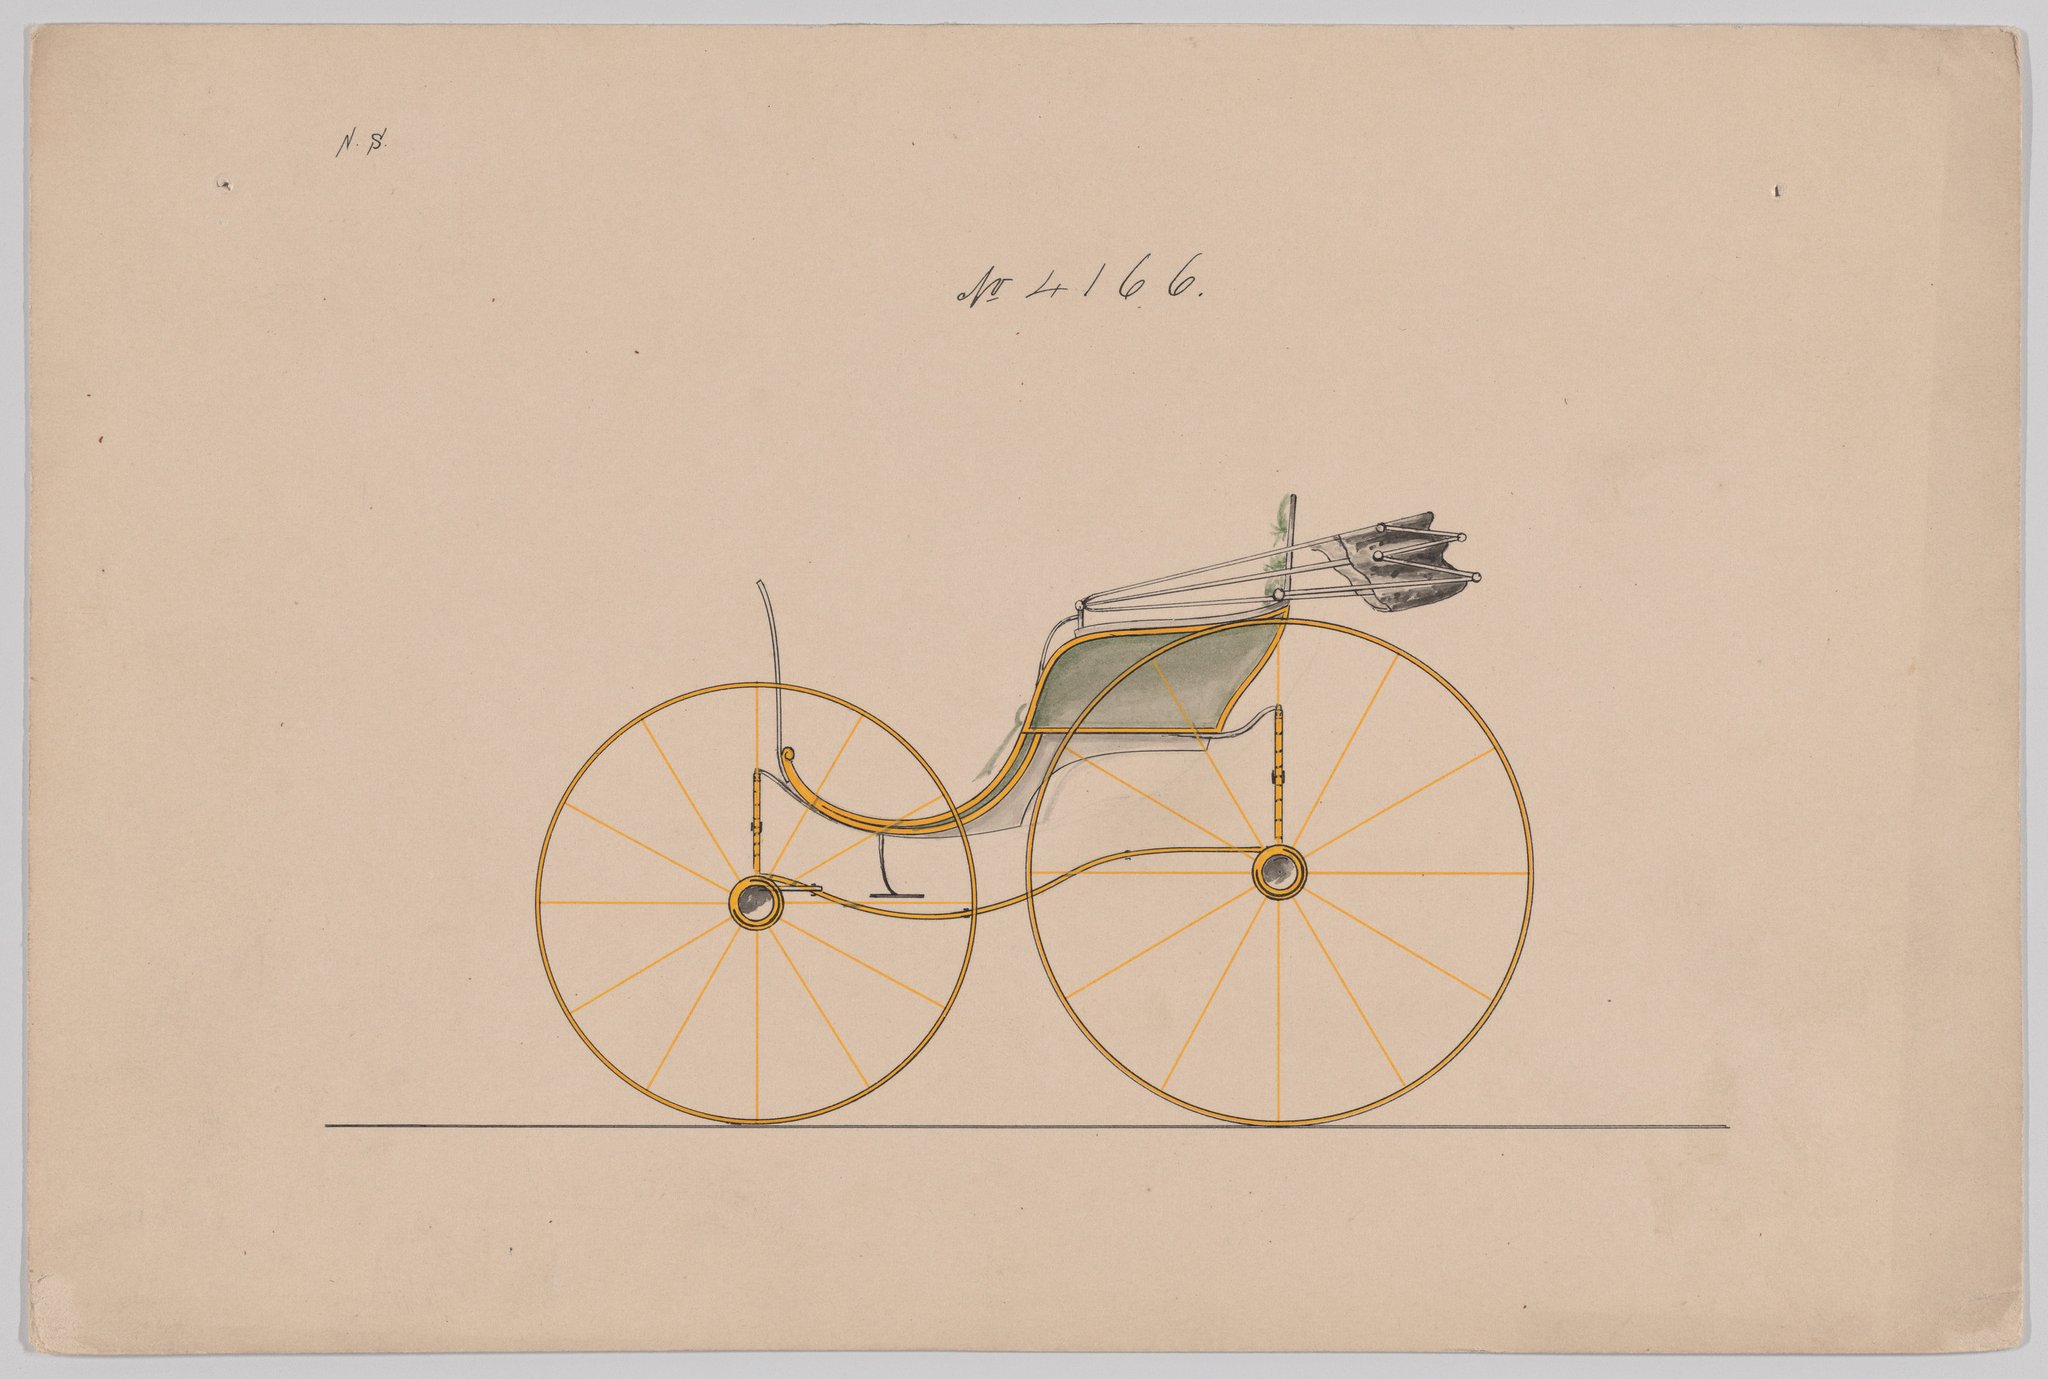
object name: drawing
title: Design for Pony Phaeton, no. 4166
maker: brewster & co.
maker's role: manufacturer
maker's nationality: american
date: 1892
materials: ink, watercolor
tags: carriages